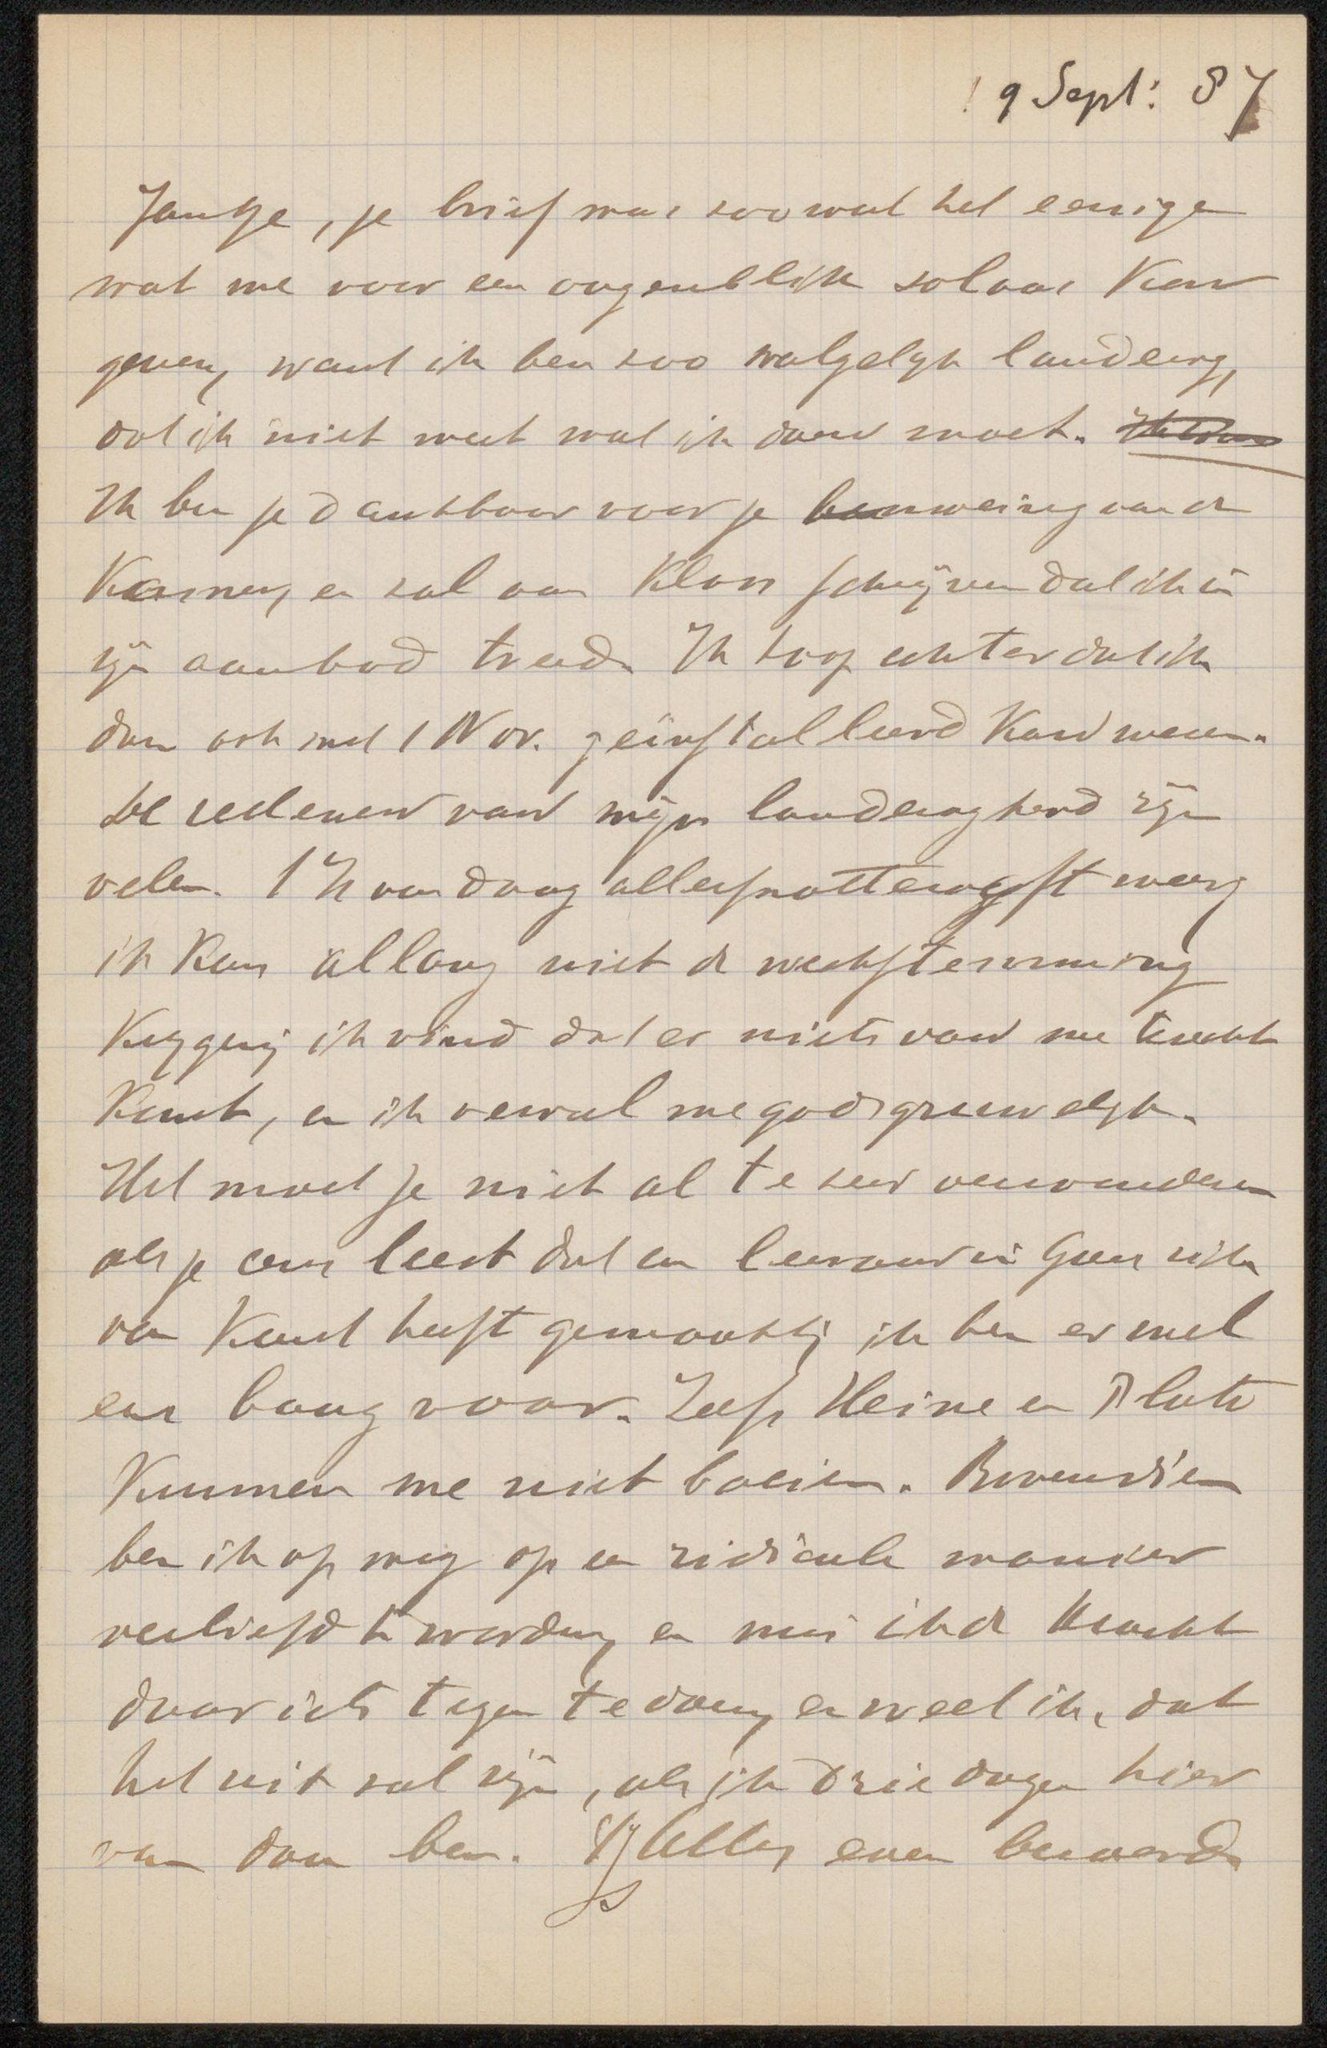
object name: letter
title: Brief aan Jan Veth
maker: chap van deventer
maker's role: kunstcriticus, scheikundige, schrijver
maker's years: 1860-1931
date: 1887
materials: ink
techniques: pen, writing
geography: goes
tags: painter, draughtsman, designer, jan veth, the hague, carel vosmaer, passions, emotions, affections, the graphic arts, money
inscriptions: collector's mark: ‘RPK’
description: Brief gedateerd 19 september 1887 in latere hand.